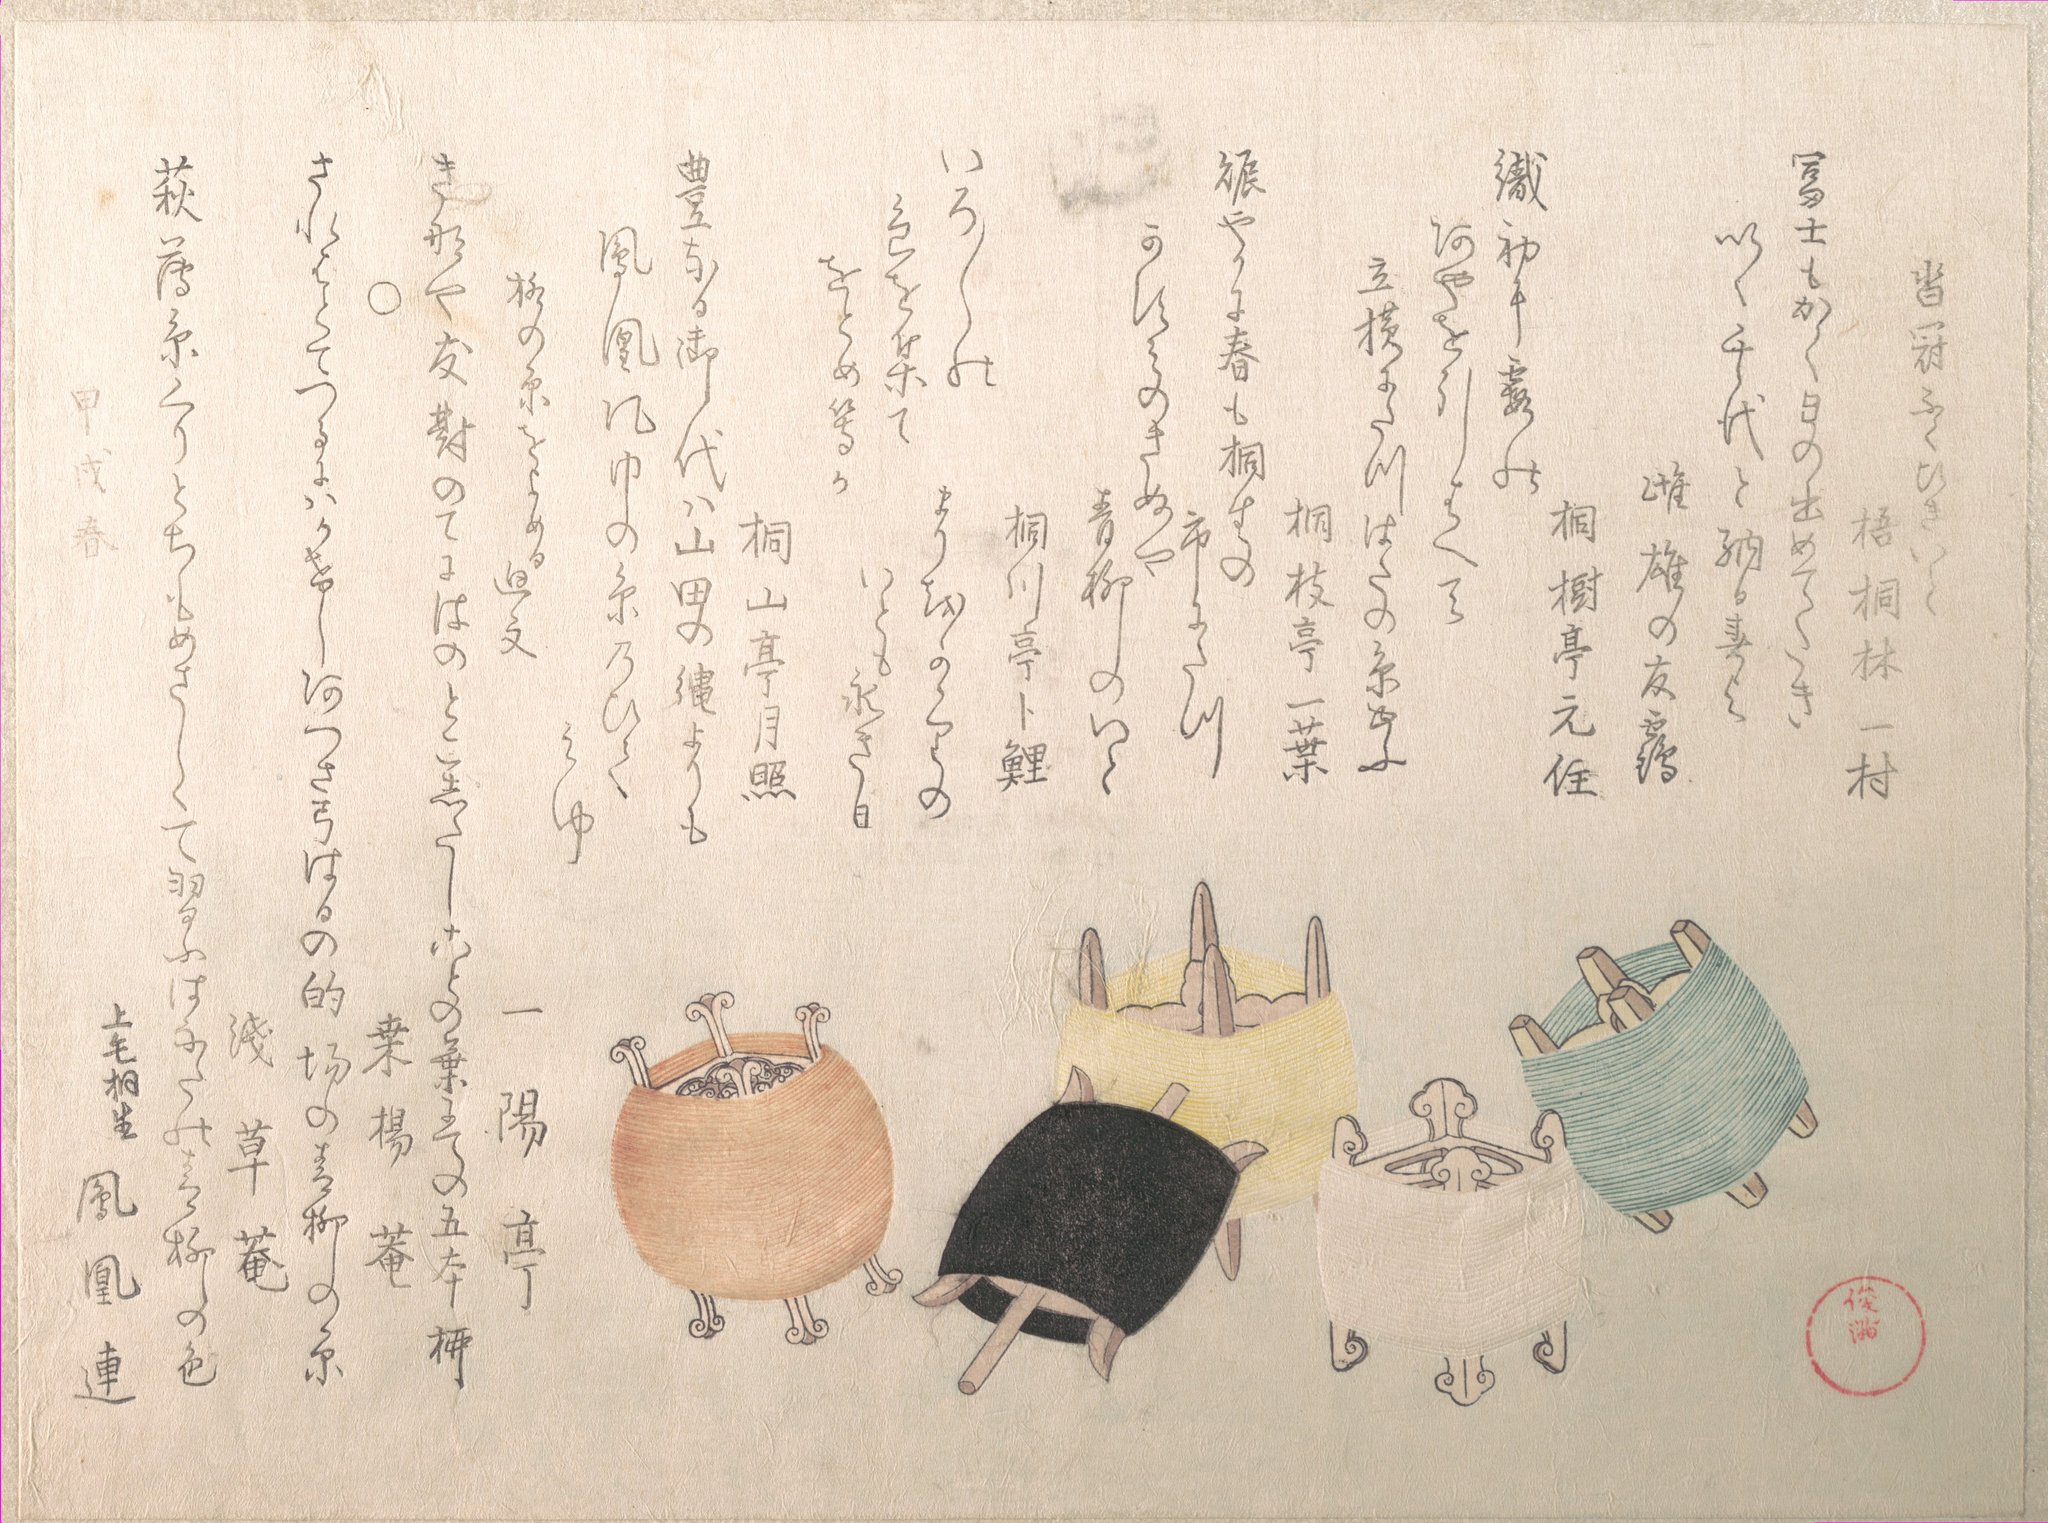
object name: print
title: Spools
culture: japanese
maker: kubo shunman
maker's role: artist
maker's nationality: japanese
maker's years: 1757-1820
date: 1814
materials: ink, paper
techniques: surimono, woodblock print